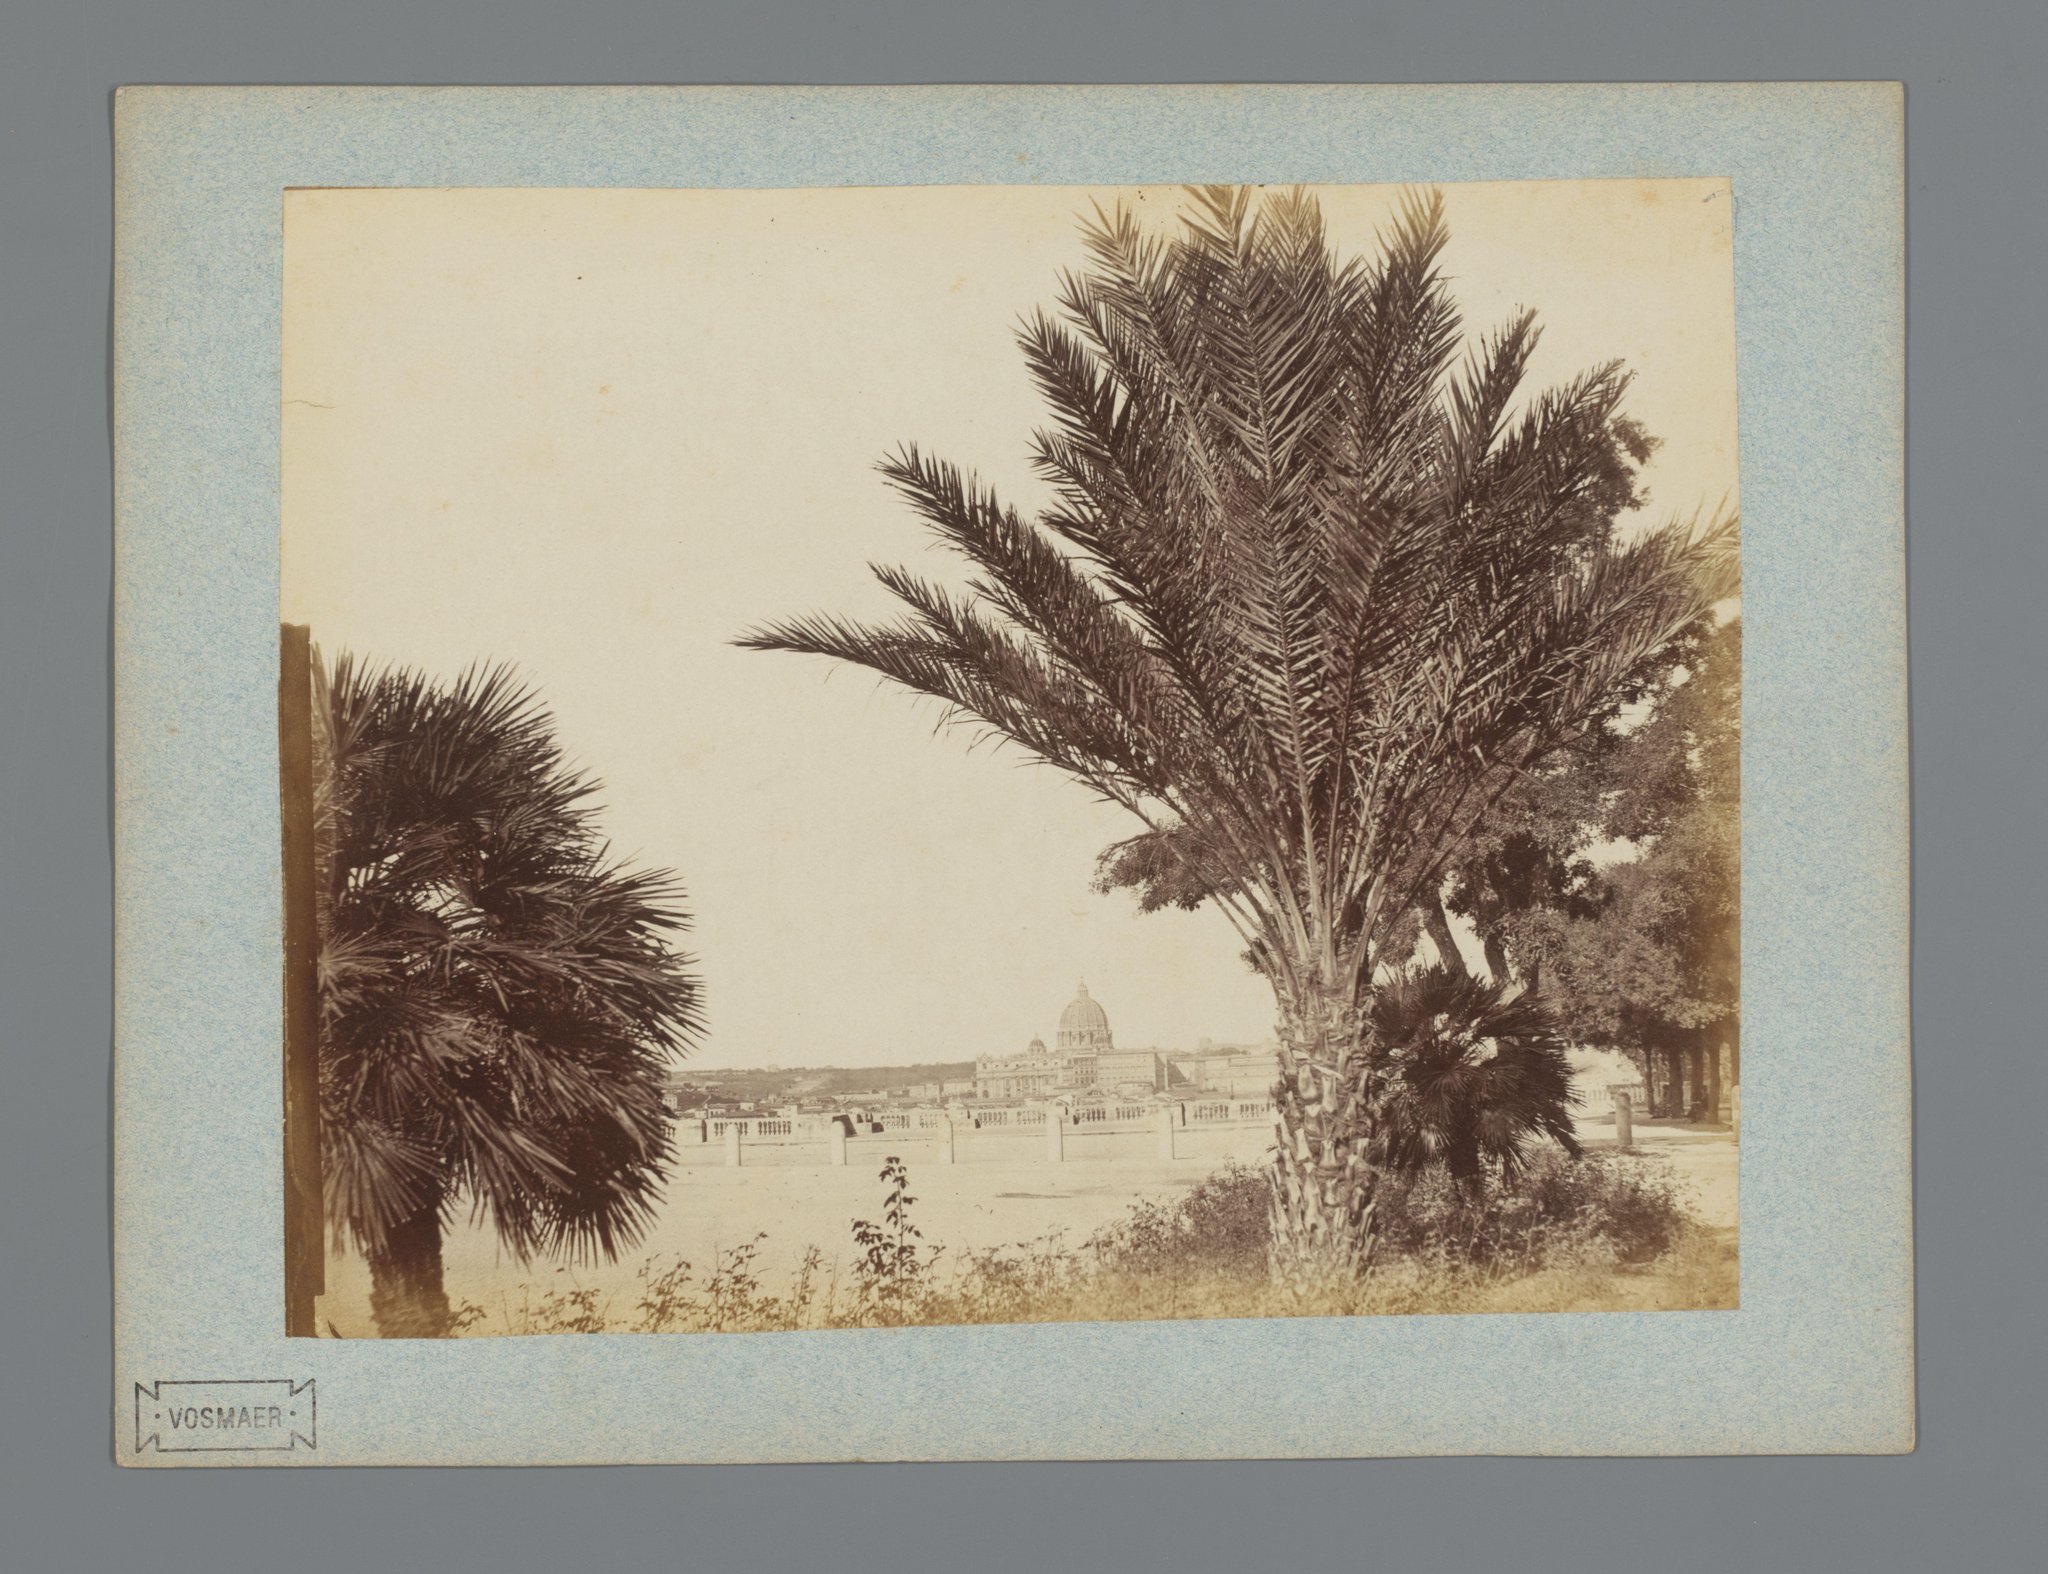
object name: photograph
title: Gezicht op de koepel van een kathedraal met op de voorgrond palmbomen, Italië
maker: Anonymous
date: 1851-1890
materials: cardboard, paper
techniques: albumen print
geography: italy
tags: parts of church exterior and annexes: dome, trees: palm-tree, italy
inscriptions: collector's mark: ‘VOSMAER’